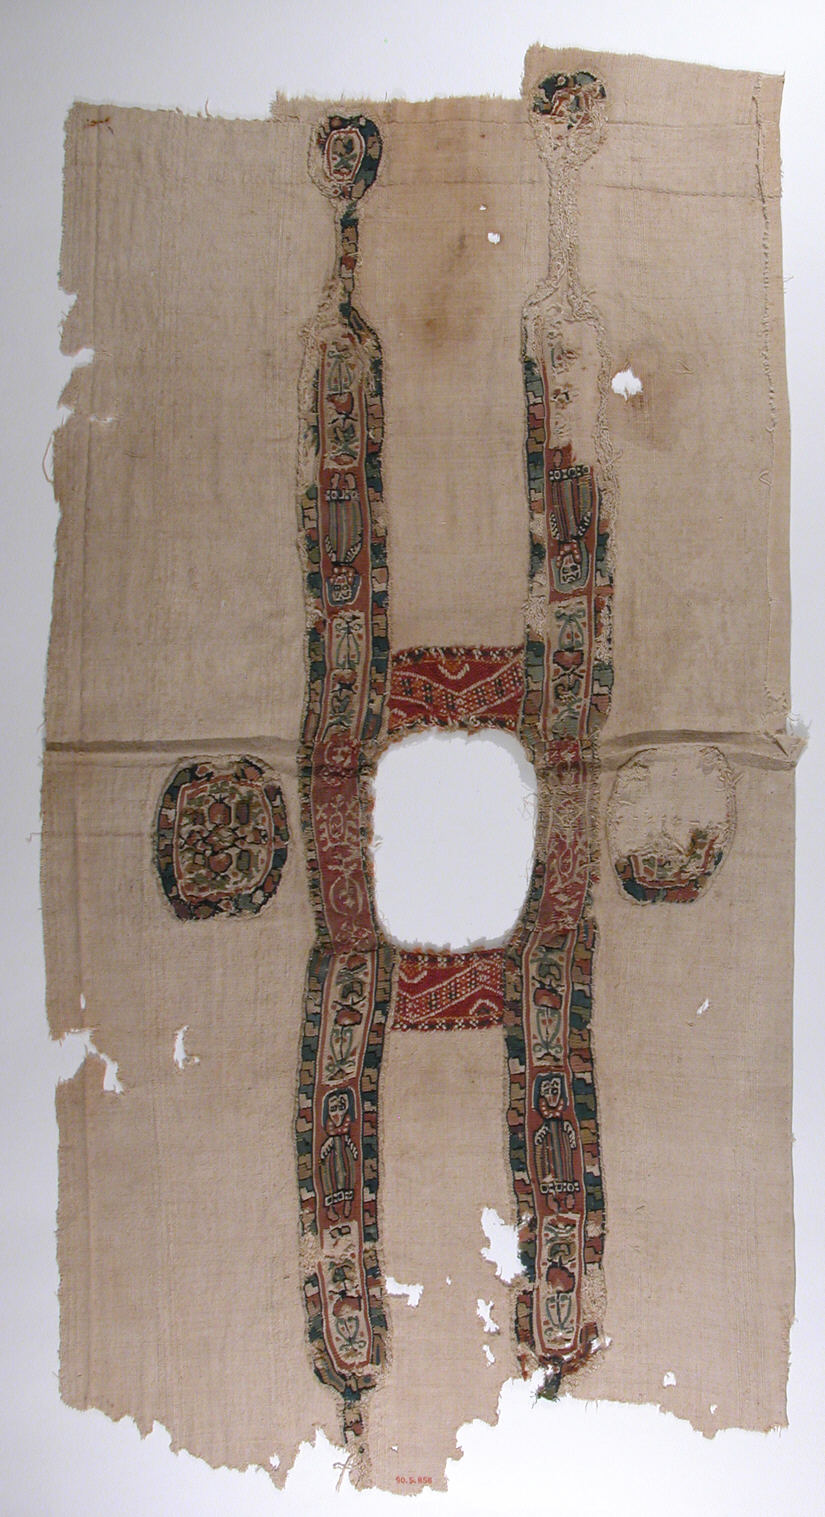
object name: tunic fragment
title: Fragment of a Tunic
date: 601-700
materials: linen, wool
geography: egypt